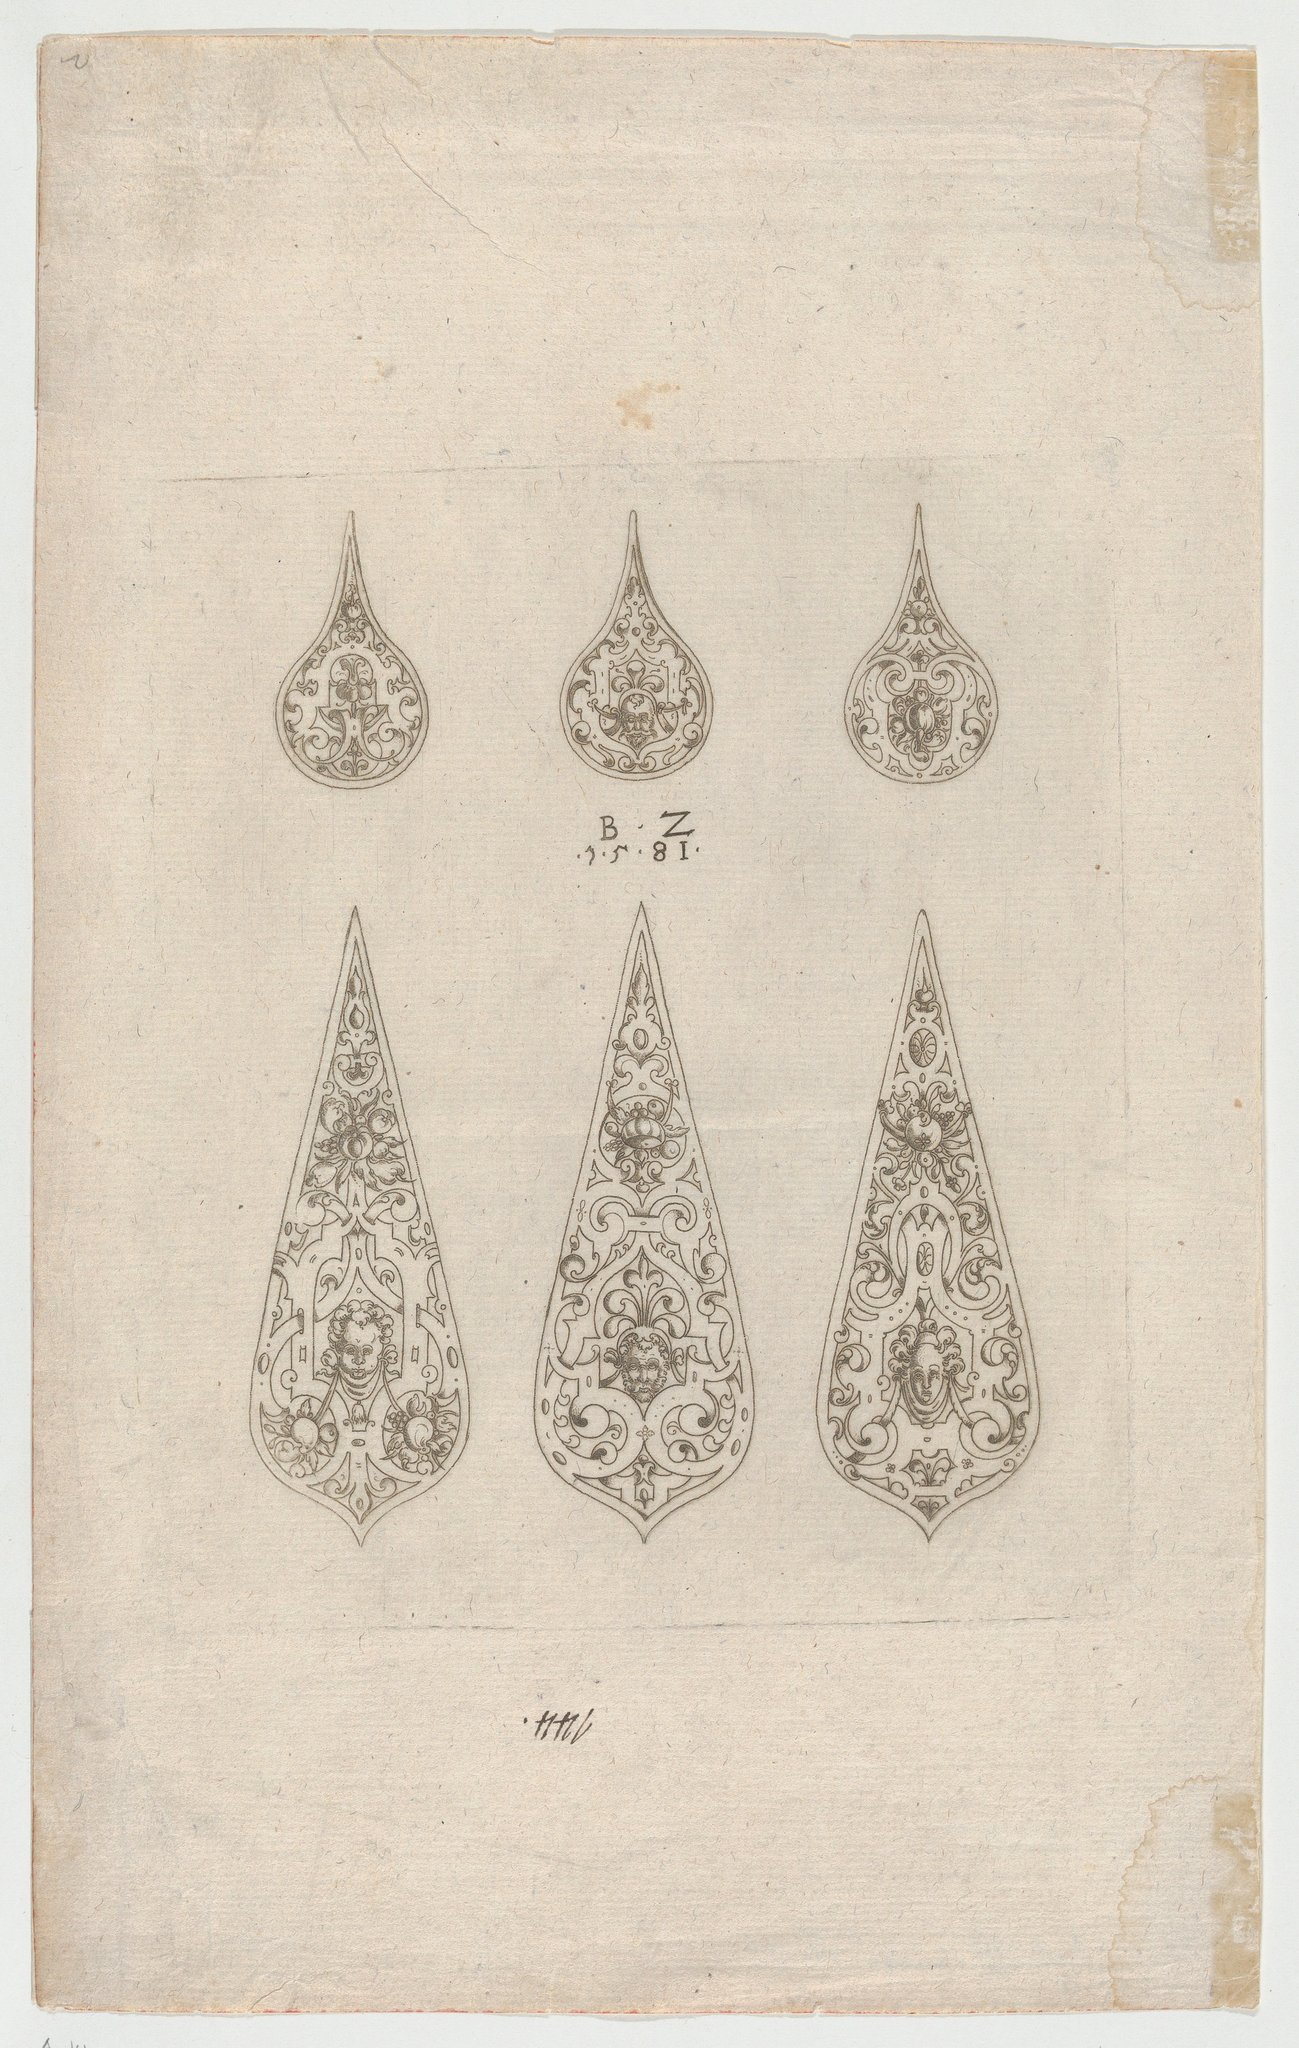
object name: print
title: Ornamental design with grotesques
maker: bernhard zan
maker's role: artist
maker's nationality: german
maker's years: 1580-1581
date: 1581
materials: metal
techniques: cutting